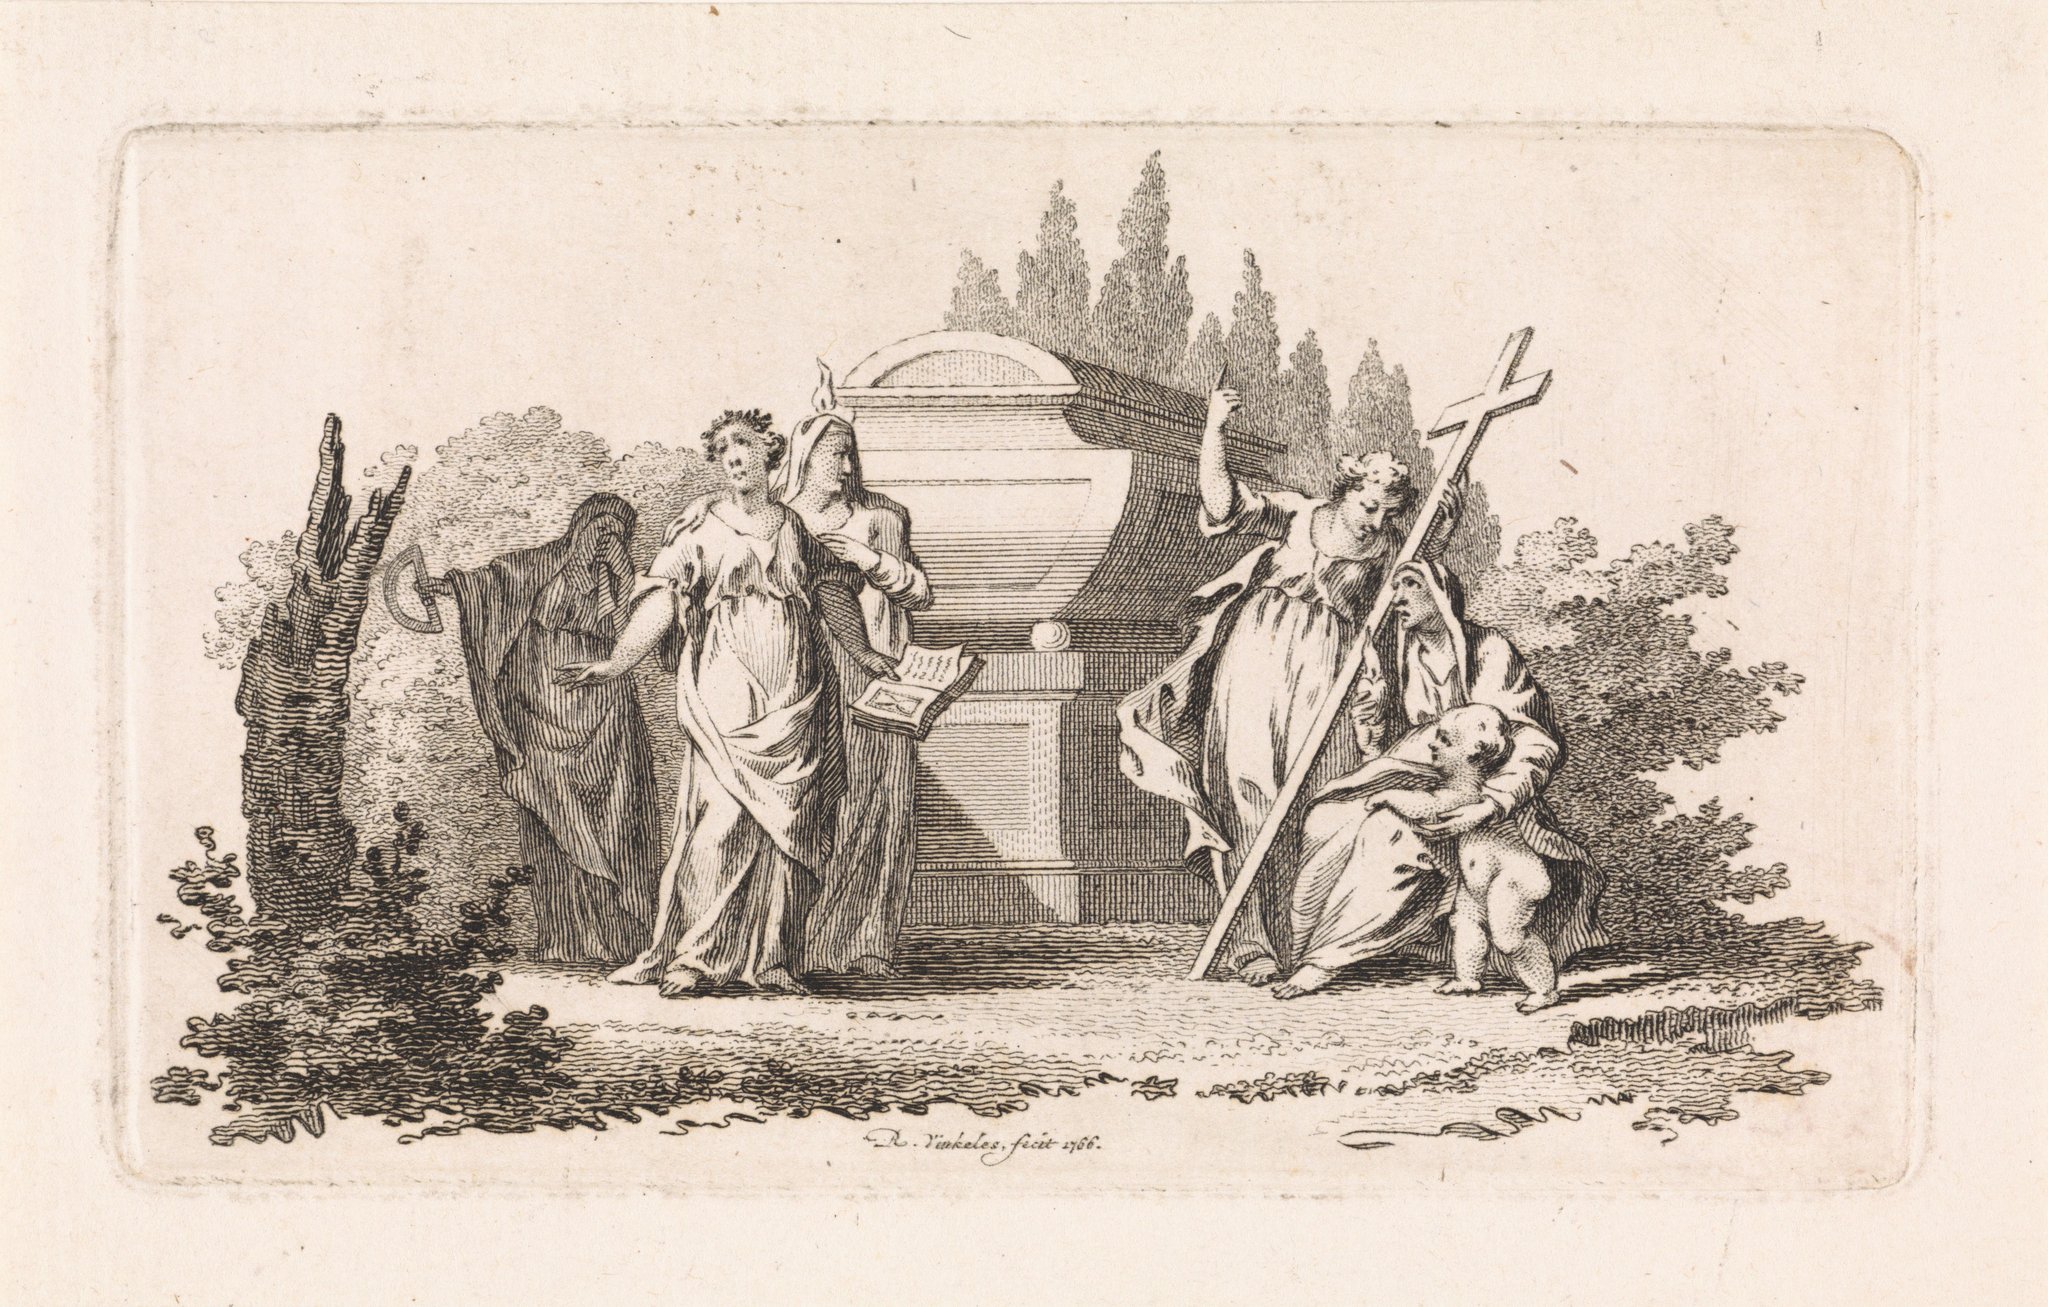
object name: print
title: Vijf vrouwelijke personificaties bij een grafmonument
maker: reinier vinkeles (i)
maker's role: draughtsman, print maker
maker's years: 1741-1816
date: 1766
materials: paper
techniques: engraving, etching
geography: amsterdam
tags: charity, 'caritas'; 'carità' (ripa) ~ one of the three theological virtues, faith, 'fides'; 'fede', 'fede catholica', 'fede christiana', 'fede christiana catholica' (ripa) ~ one of the three theological virtues, truth; 'verità' (ripa), grave, tomb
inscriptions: collector's mark: Lugt 240